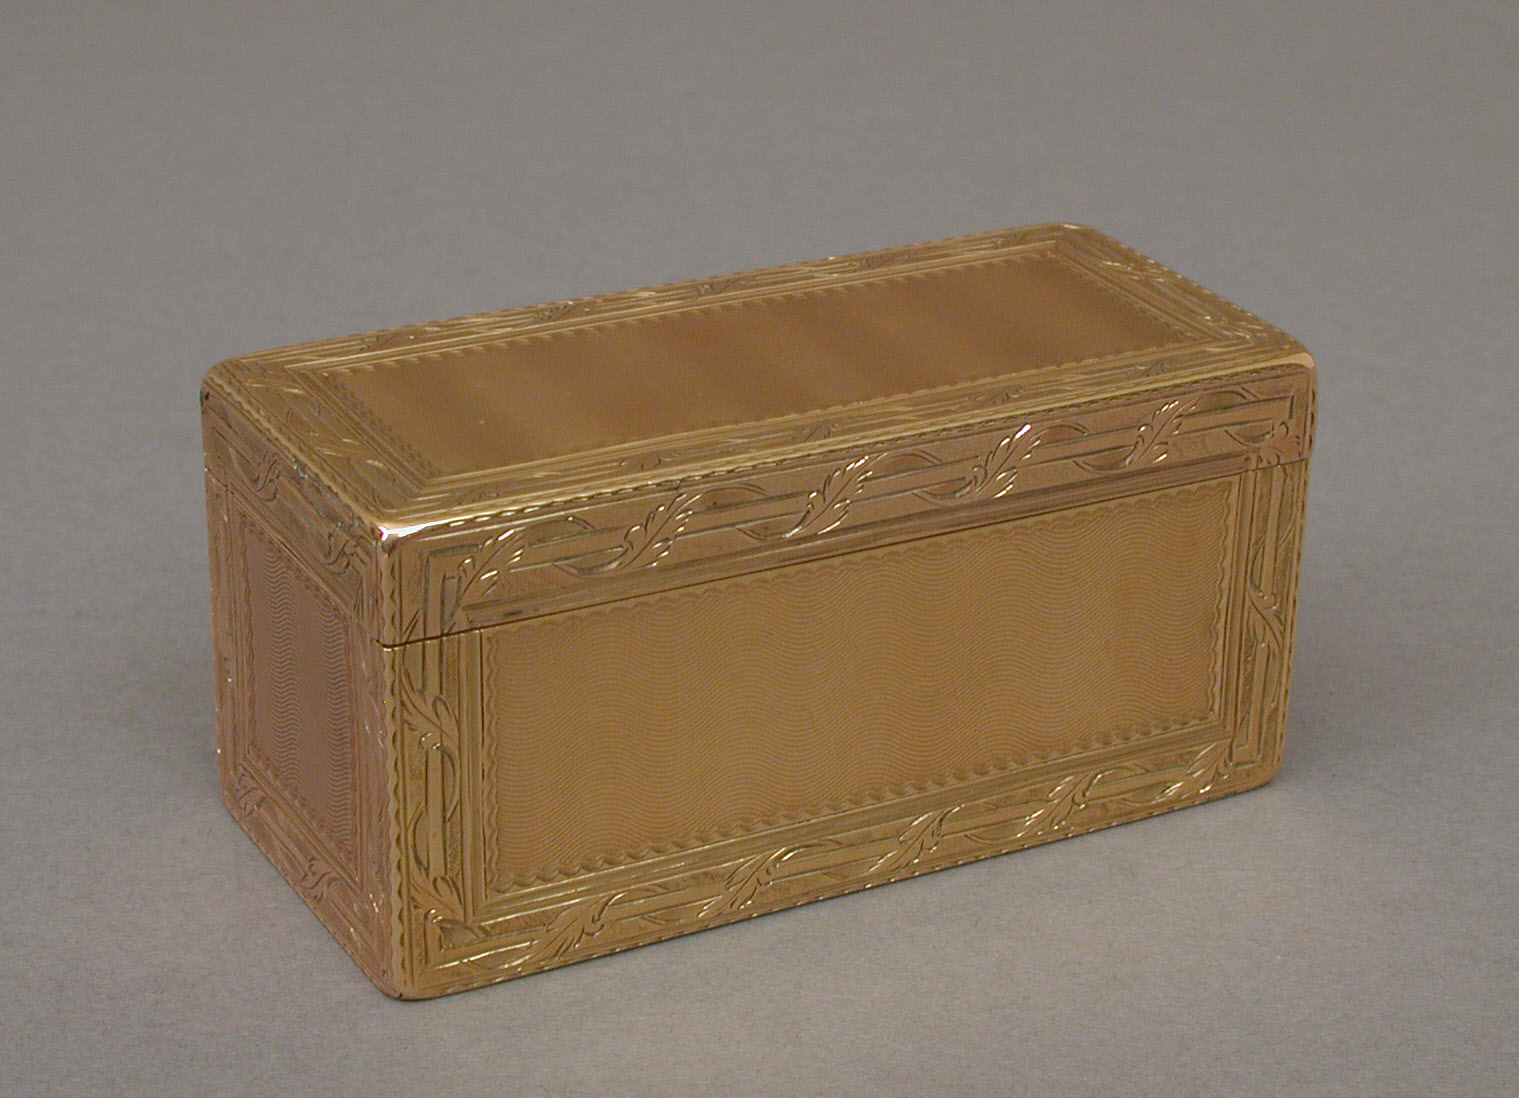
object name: snuffbox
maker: claude héricourt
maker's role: maker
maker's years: 1715-1815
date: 1768-1769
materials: gold